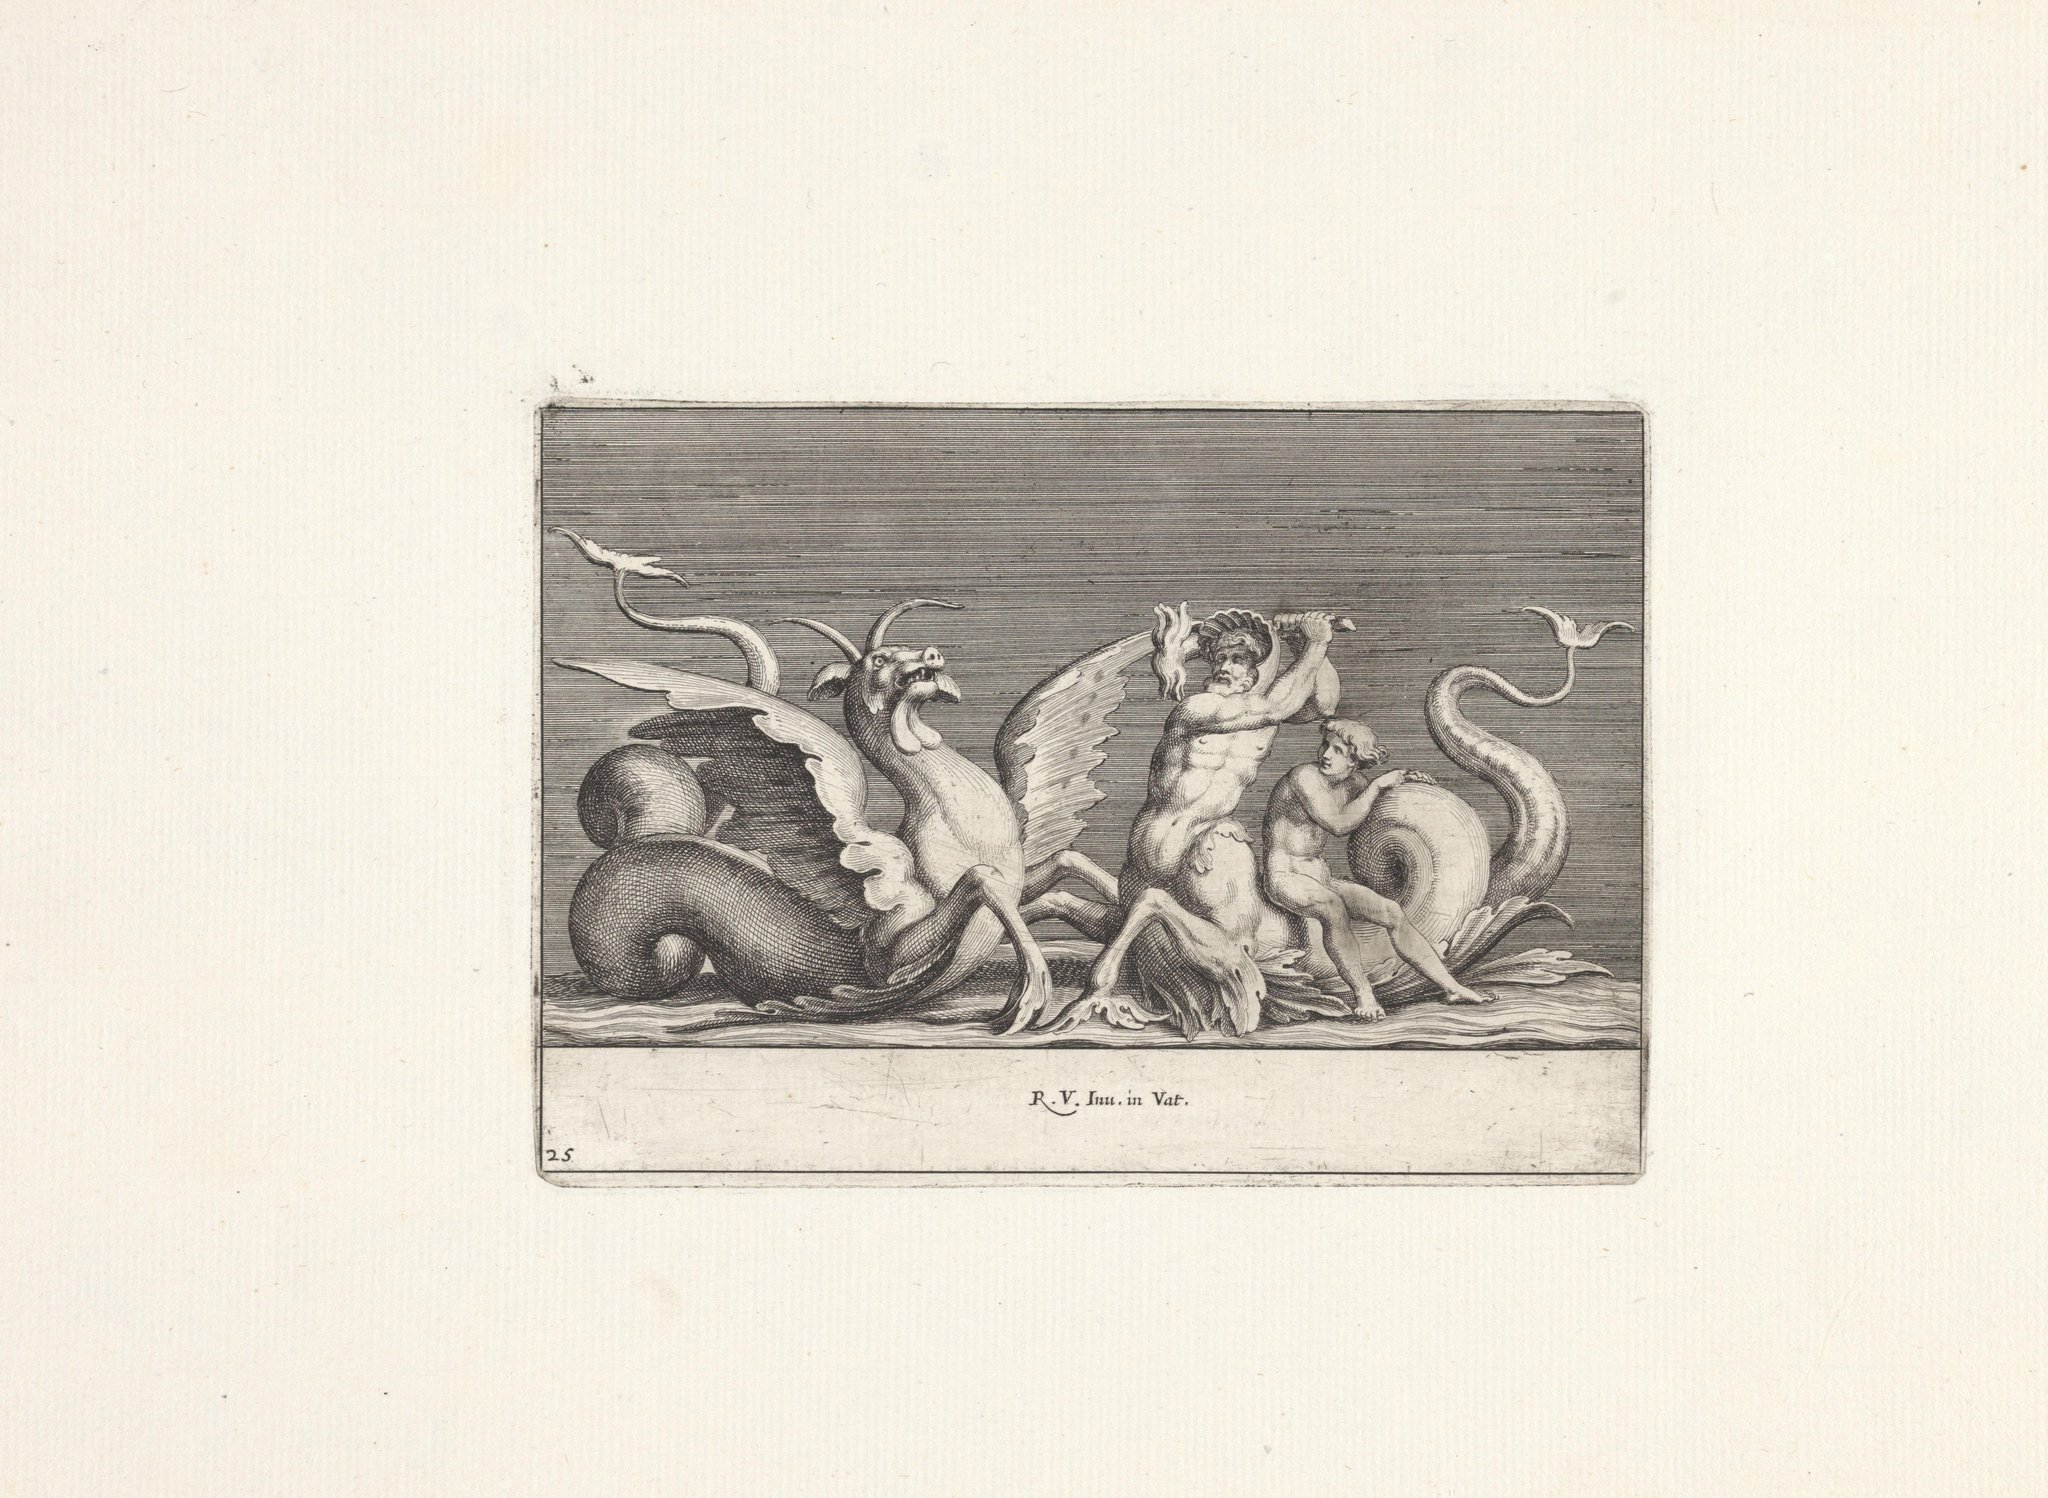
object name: print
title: Triton in gevecht met een zeemonster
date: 1645-1700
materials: paper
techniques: engraving, etching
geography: vatican city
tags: triton(s), monsters of the sea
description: Prent uit een reeks naar de gipsen reliëfs door Rafaël en uitgevoerd door zijn assistenten in de Vaticaanse Loggia.